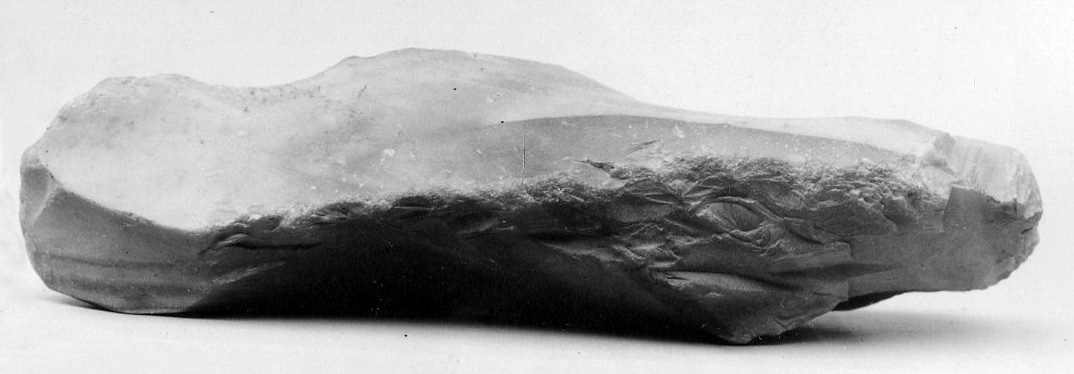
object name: tool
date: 1295-1070 BCE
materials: stone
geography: egypt